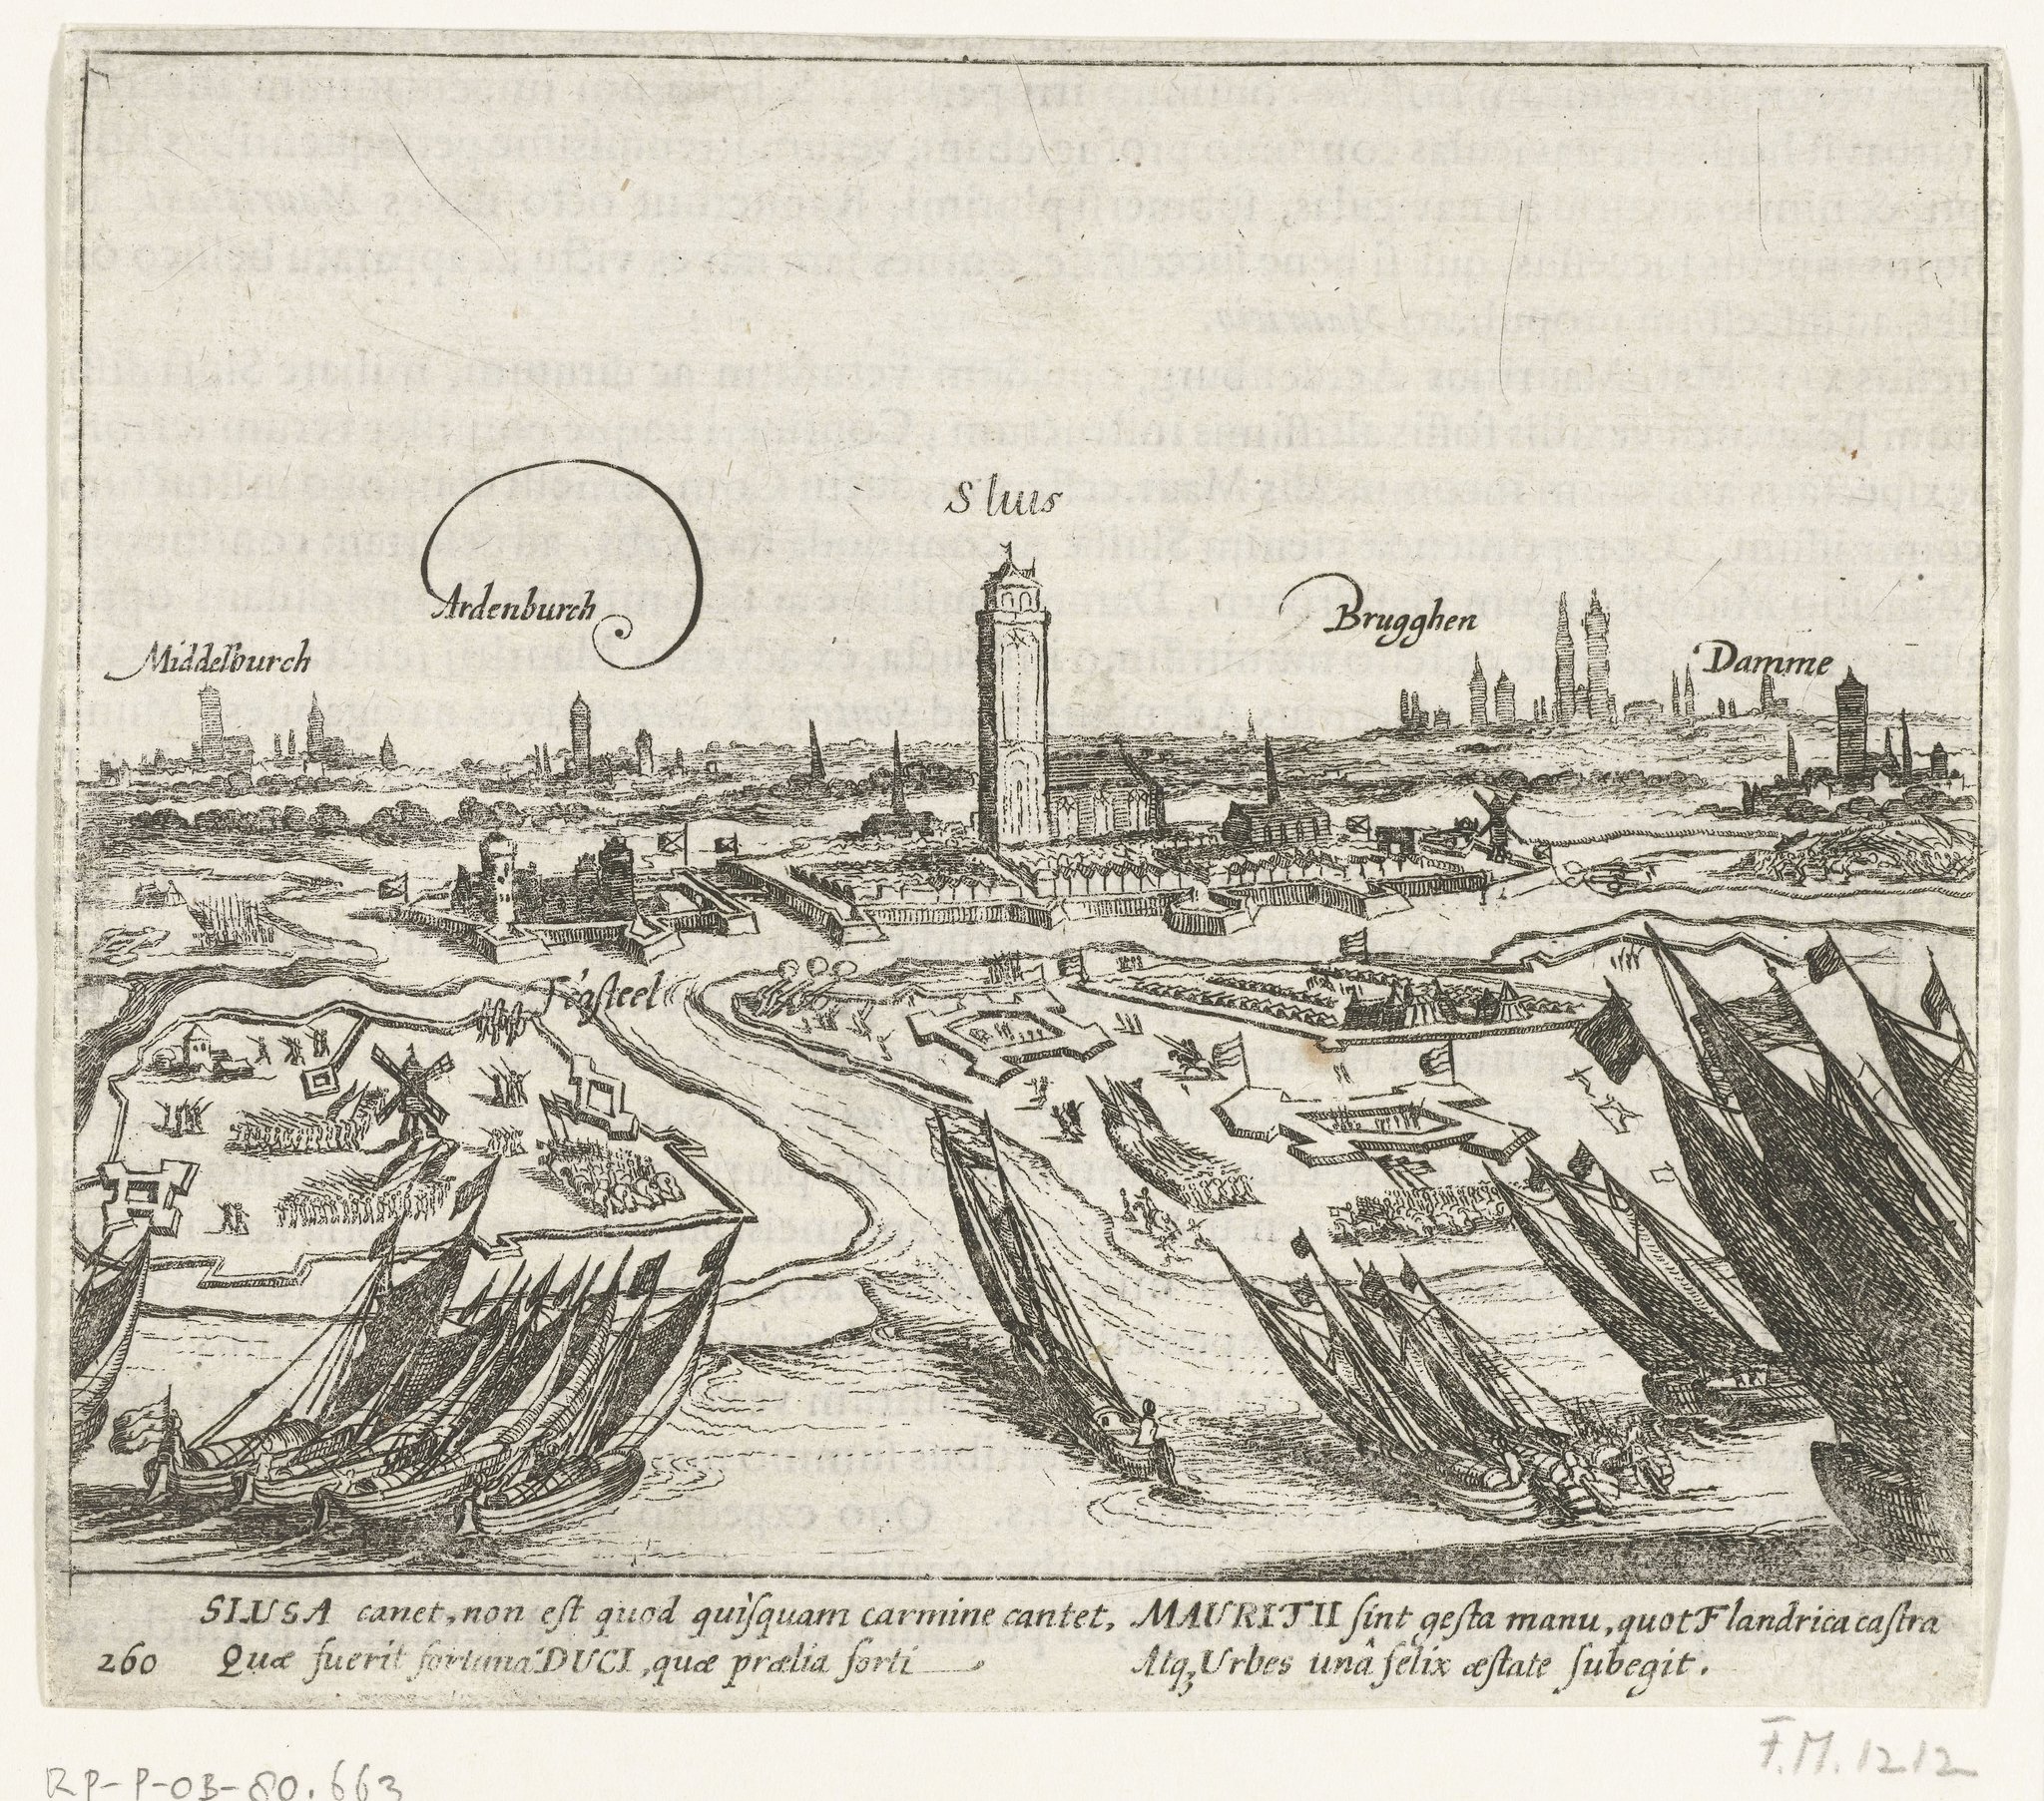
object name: print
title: Maurits verovert Sluis, 1604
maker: simon frisius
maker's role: print maker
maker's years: 1570-1628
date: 1613-1615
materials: paper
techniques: etching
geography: northern netherlands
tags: the hague, maurice (prince of orange), siege, position war, capture of city (after the siege)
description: Sluis belegerd en veroverd door Maurits, 20 augustus 1604. Op de voorgrond de Spaanse schepen die tot ontzet aankomen. Met onderschrift van 4 regels in het Latijn. Genummerd 260. Bedrukt op achterzijde met tekst in het Latijn.